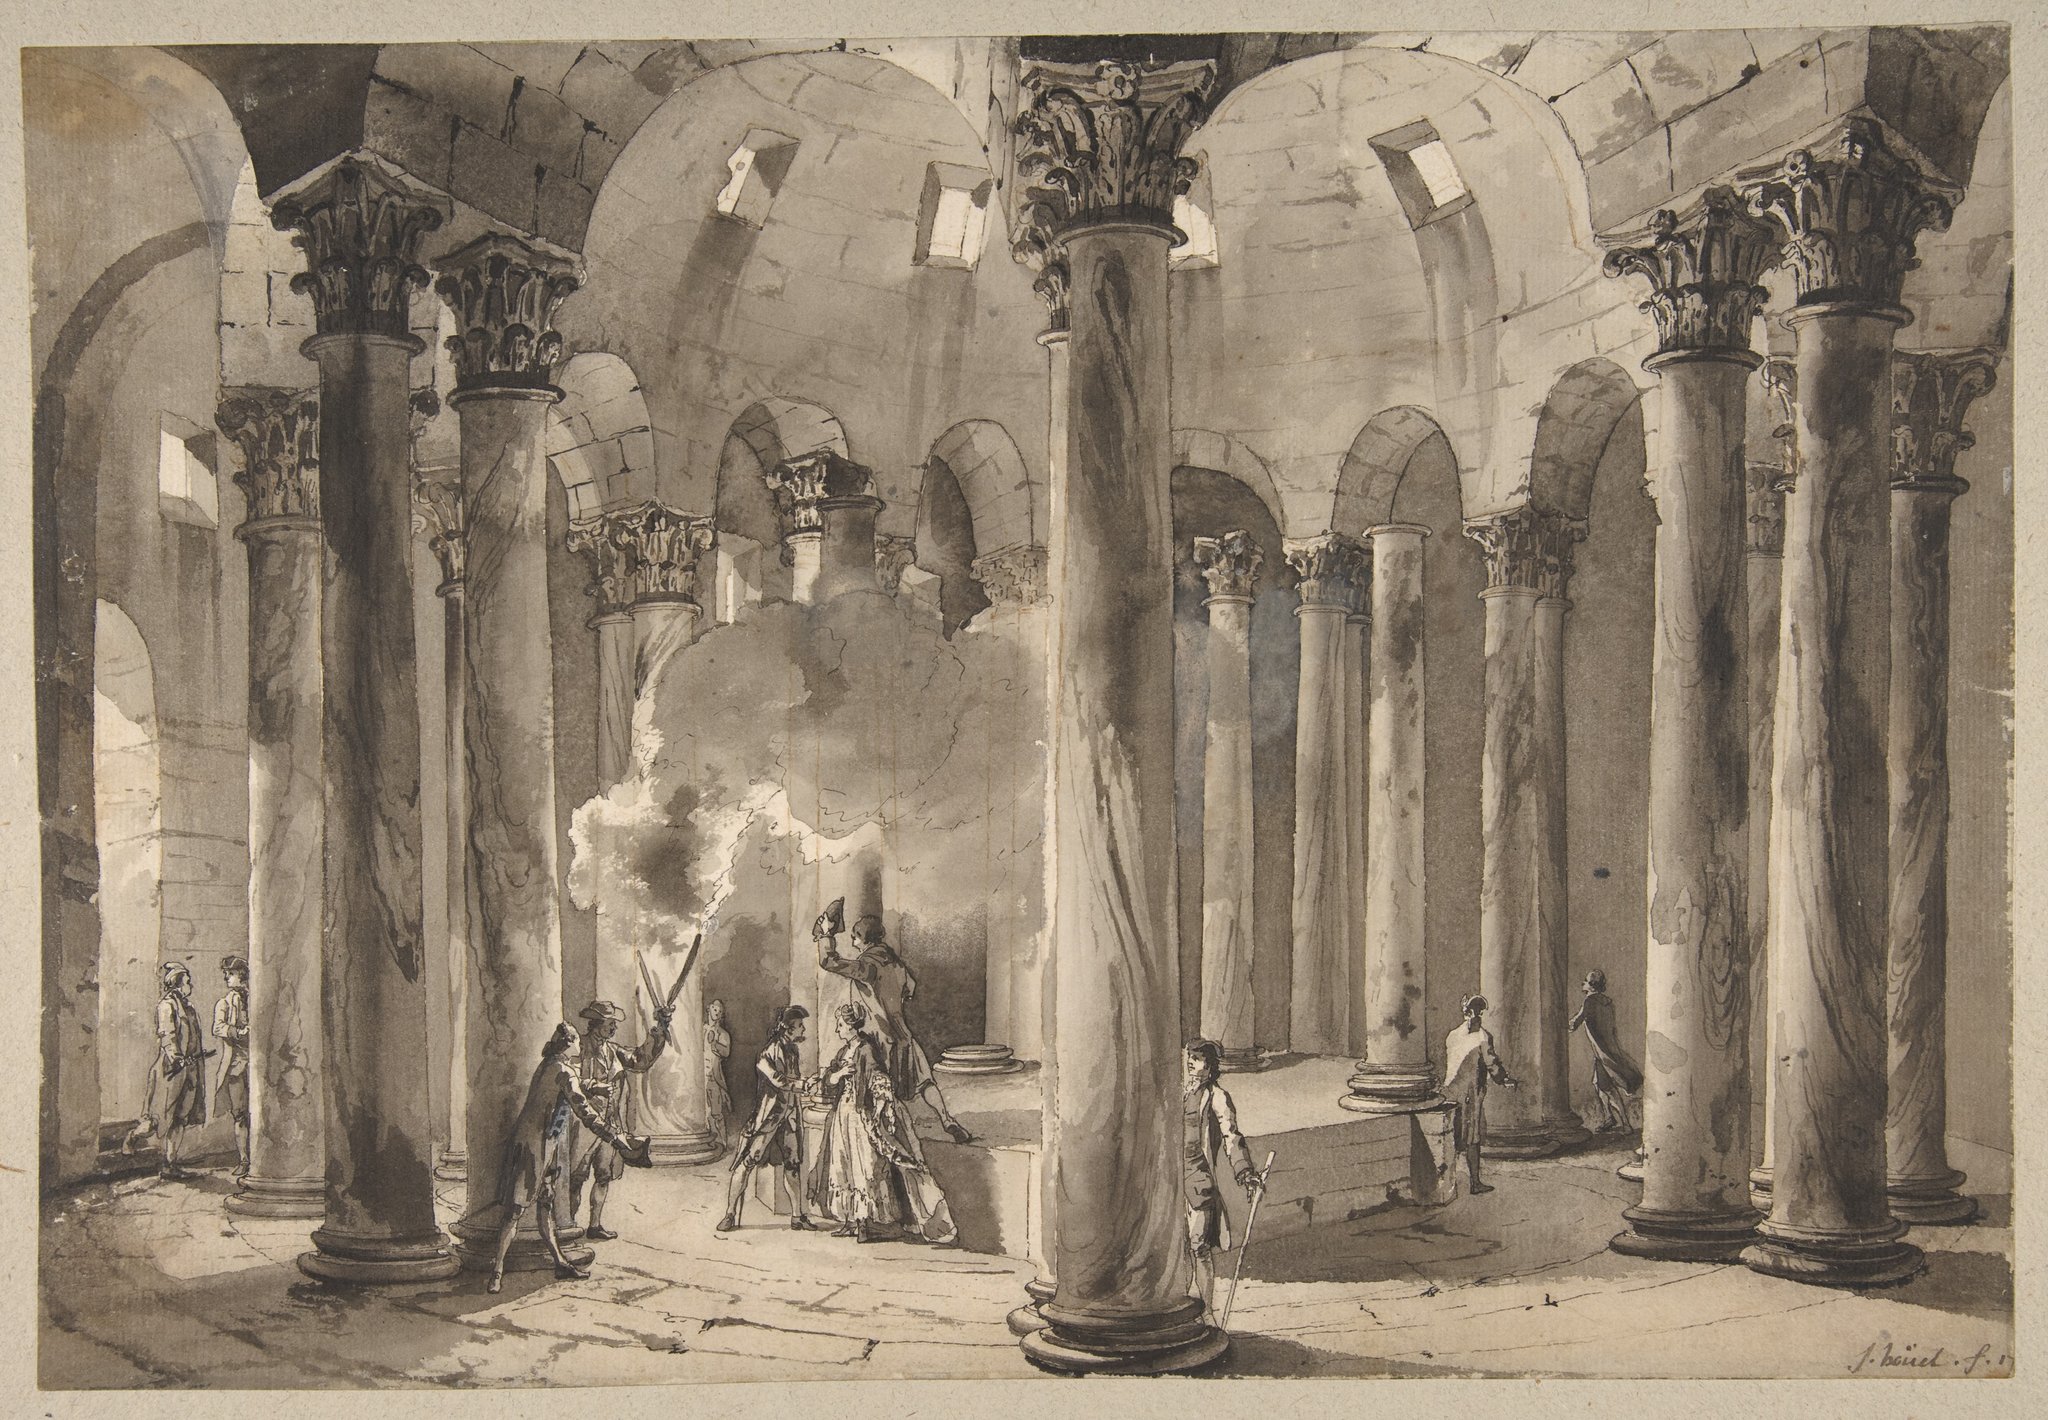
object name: drawing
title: Visitors with Torches Inside a Circular Building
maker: jean pierre louis laurent hoüel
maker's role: artist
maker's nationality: french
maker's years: 1735-1813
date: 1769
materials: chalk, ink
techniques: heightening, pen, wash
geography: france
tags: arches,buildings,columns,men,women